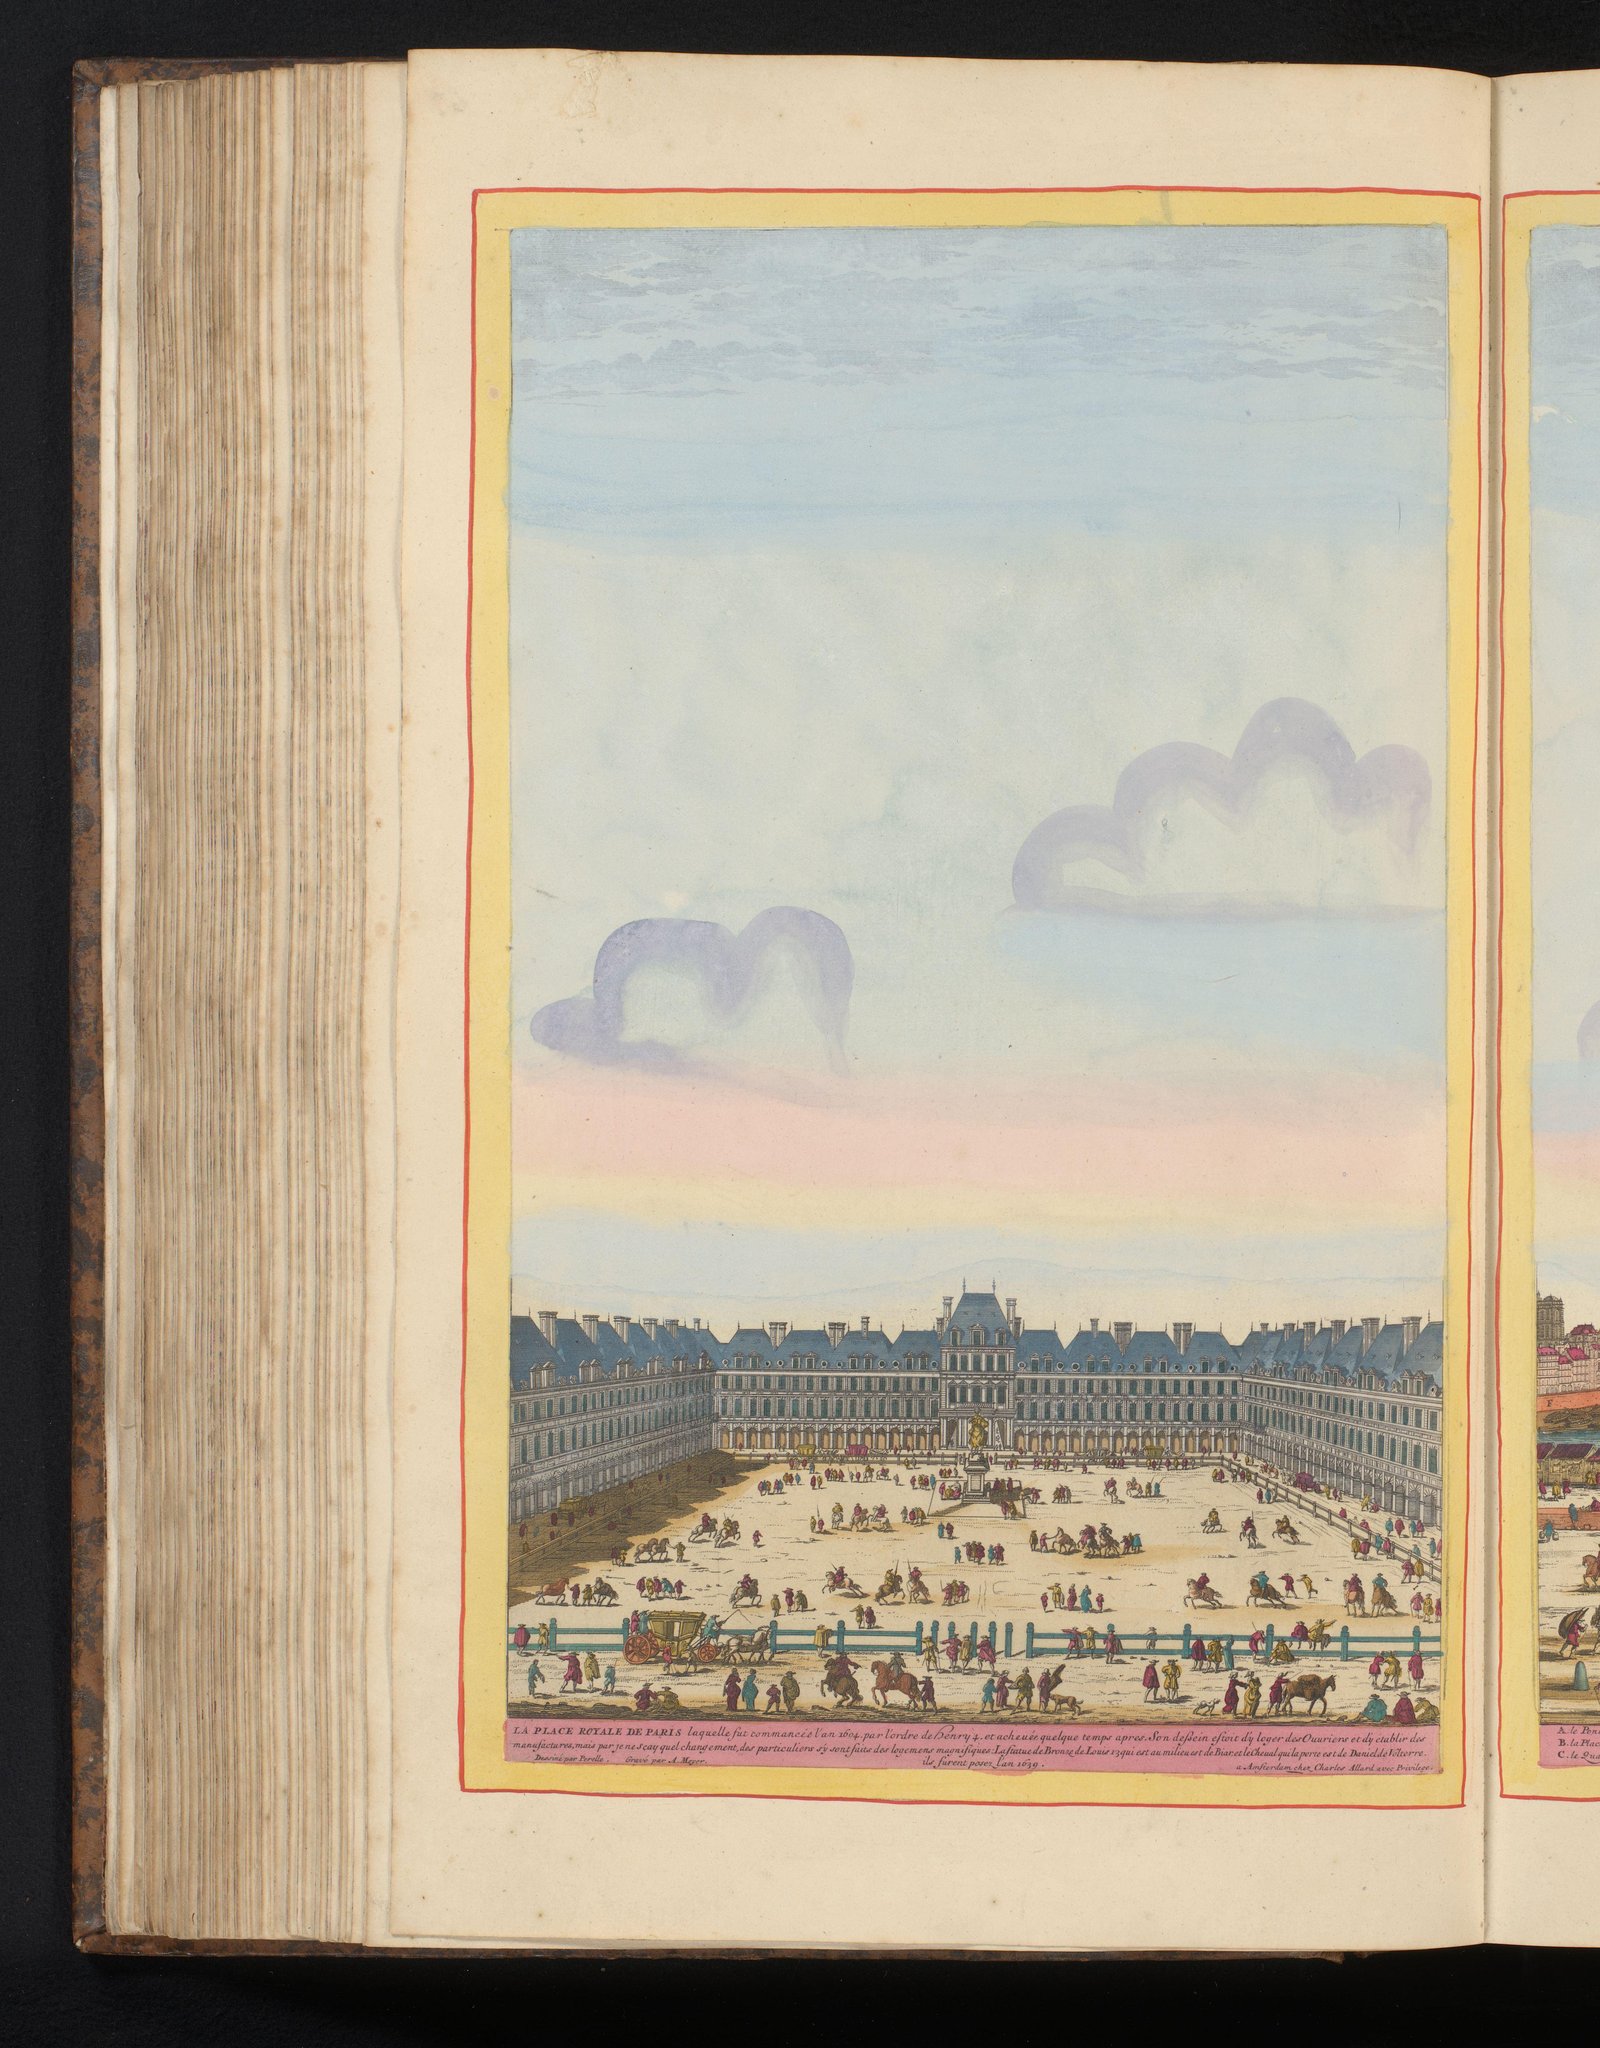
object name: album leaf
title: Gezicht op de Place Royal te Parijs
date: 1685-1695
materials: paper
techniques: engraving, etching, hand coloring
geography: northern netherlands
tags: village square, place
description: De prent is langs de bovenrand van de voorstelling afgescheurd. Het bovenste gedeelte is hoger opgeplakt, zodat de lucht hoger is geworden en het formaat van de voorstelling past bij de andere groot formaatvoorstellingen in het album.